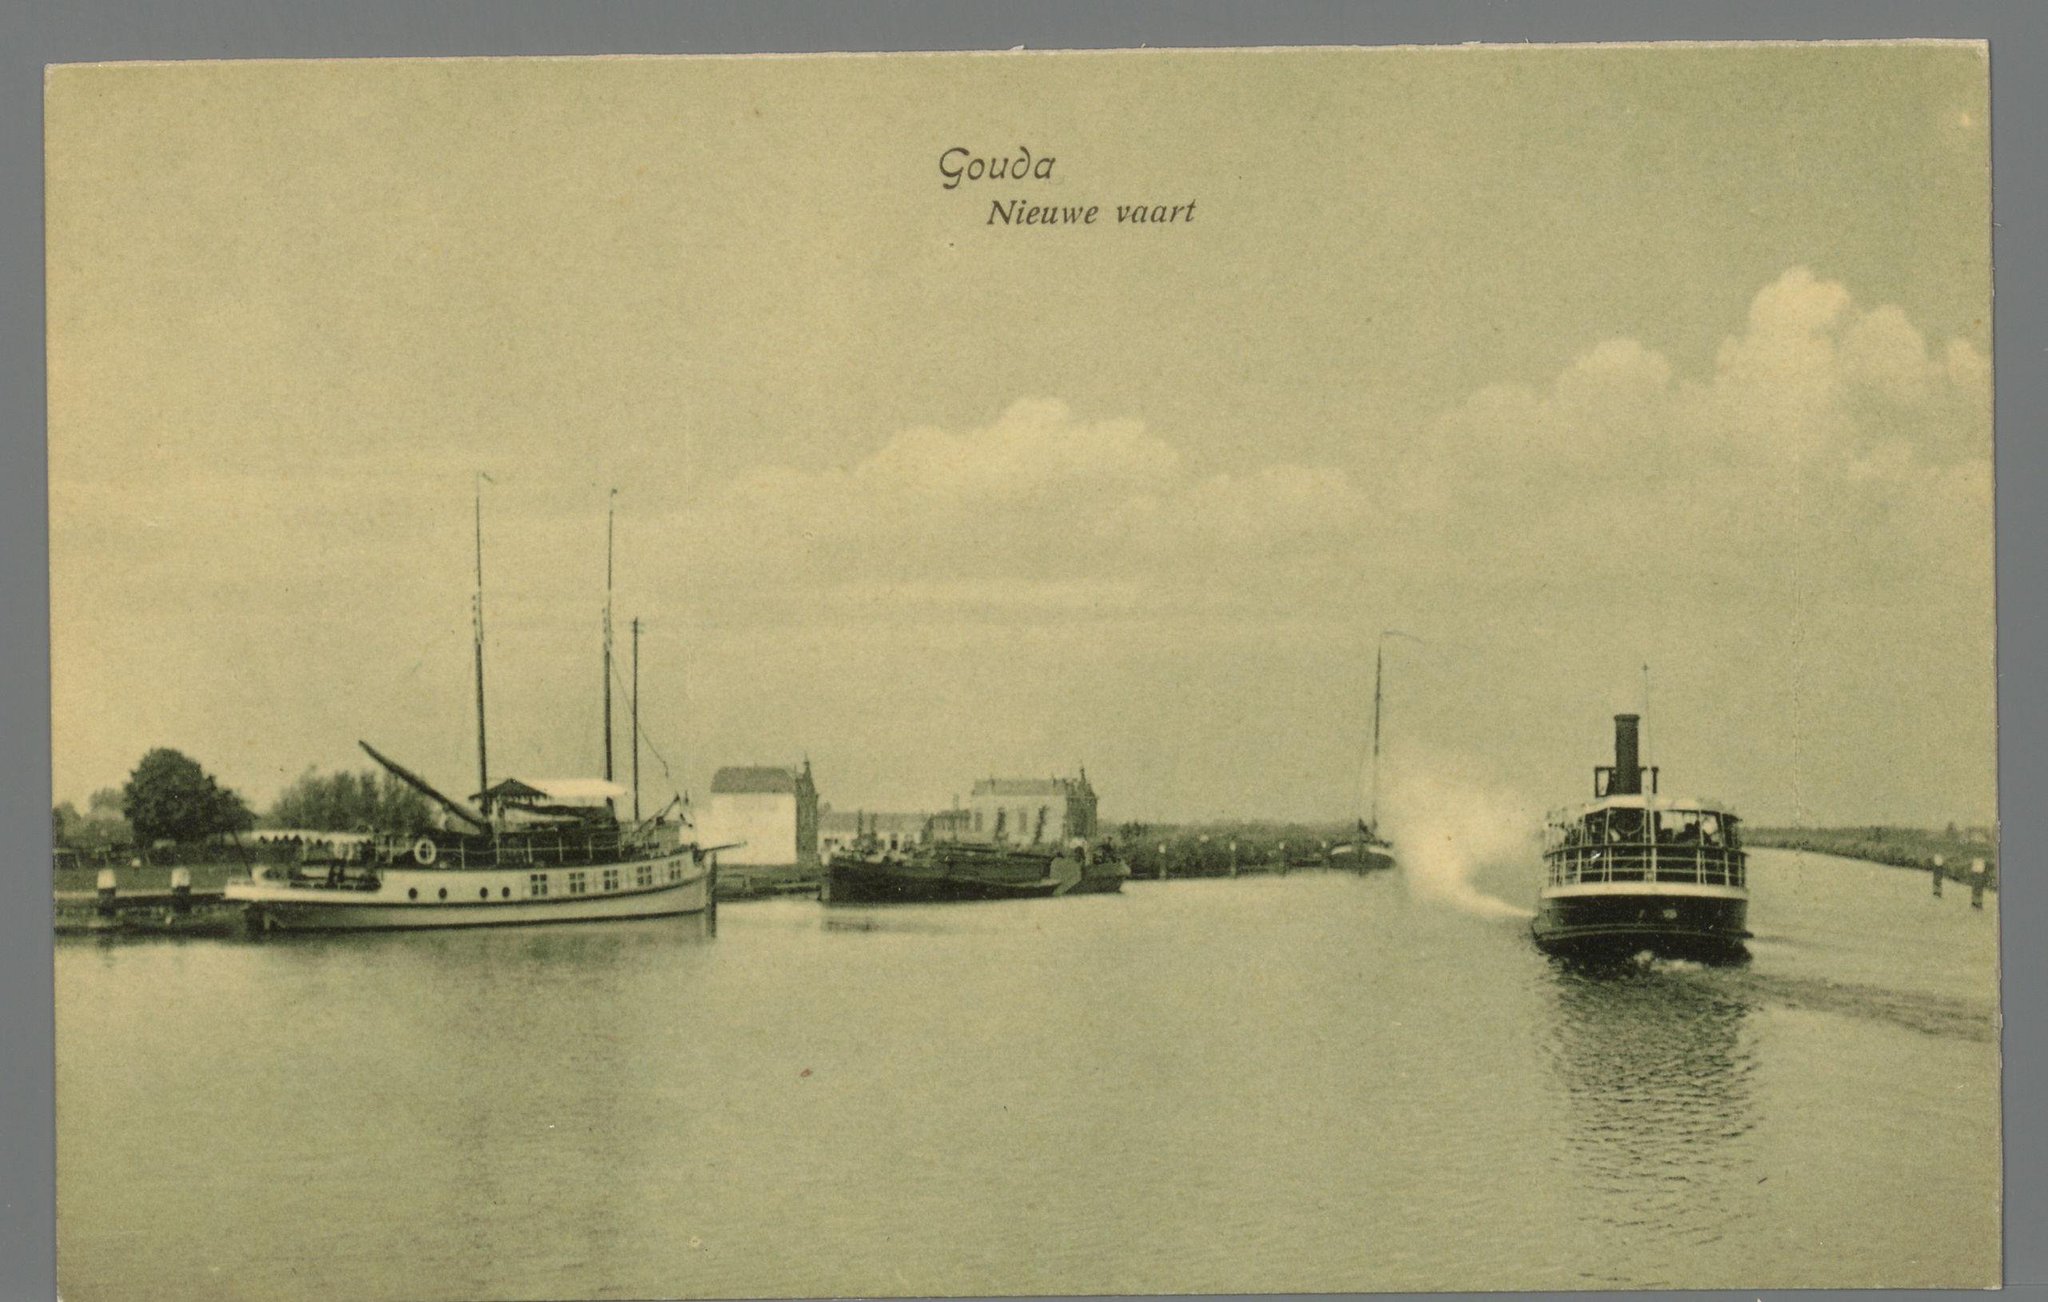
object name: photomechanical print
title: Gouda. Nieuwe vaart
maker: Anonymous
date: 1908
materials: cardboard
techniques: photograph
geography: gouda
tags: river, ships (in general), gouda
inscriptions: date